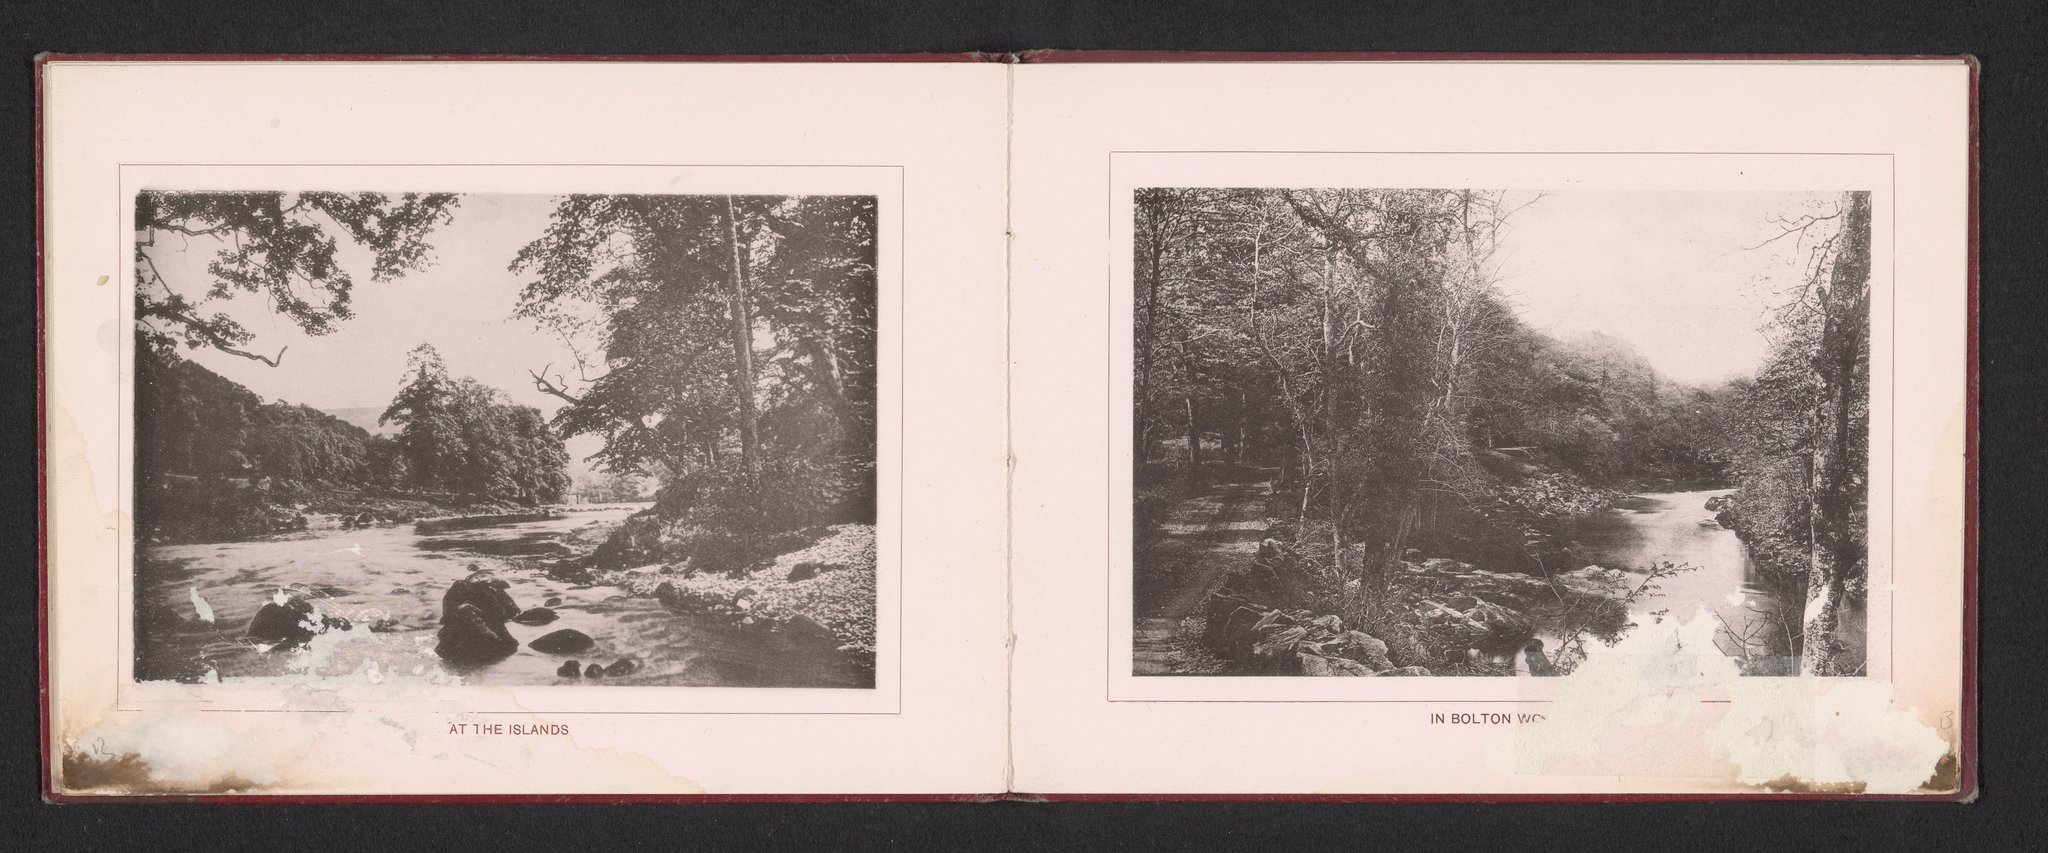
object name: photomechanical print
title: In Bolton Wo[...]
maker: Anonymous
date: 1890-1900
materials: linen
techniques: photograph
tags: river, forest, wood